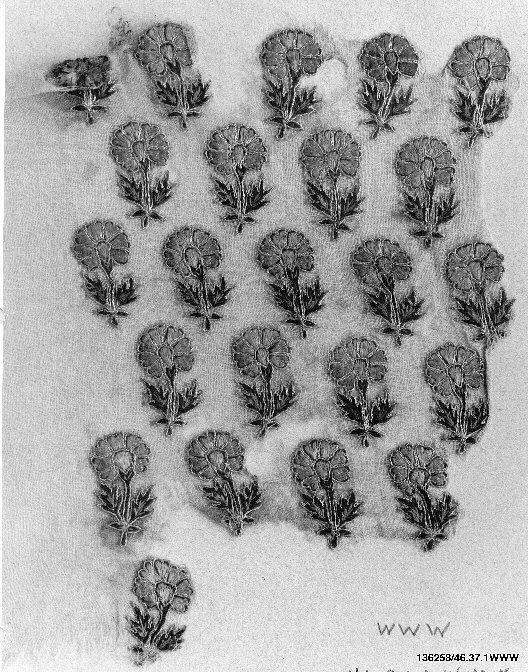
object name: turban fragment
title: Fragment of Turban Cloth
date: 1701-1800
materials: cotton, metal thread, silk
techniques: embroidery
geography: bangladesh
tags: flowers